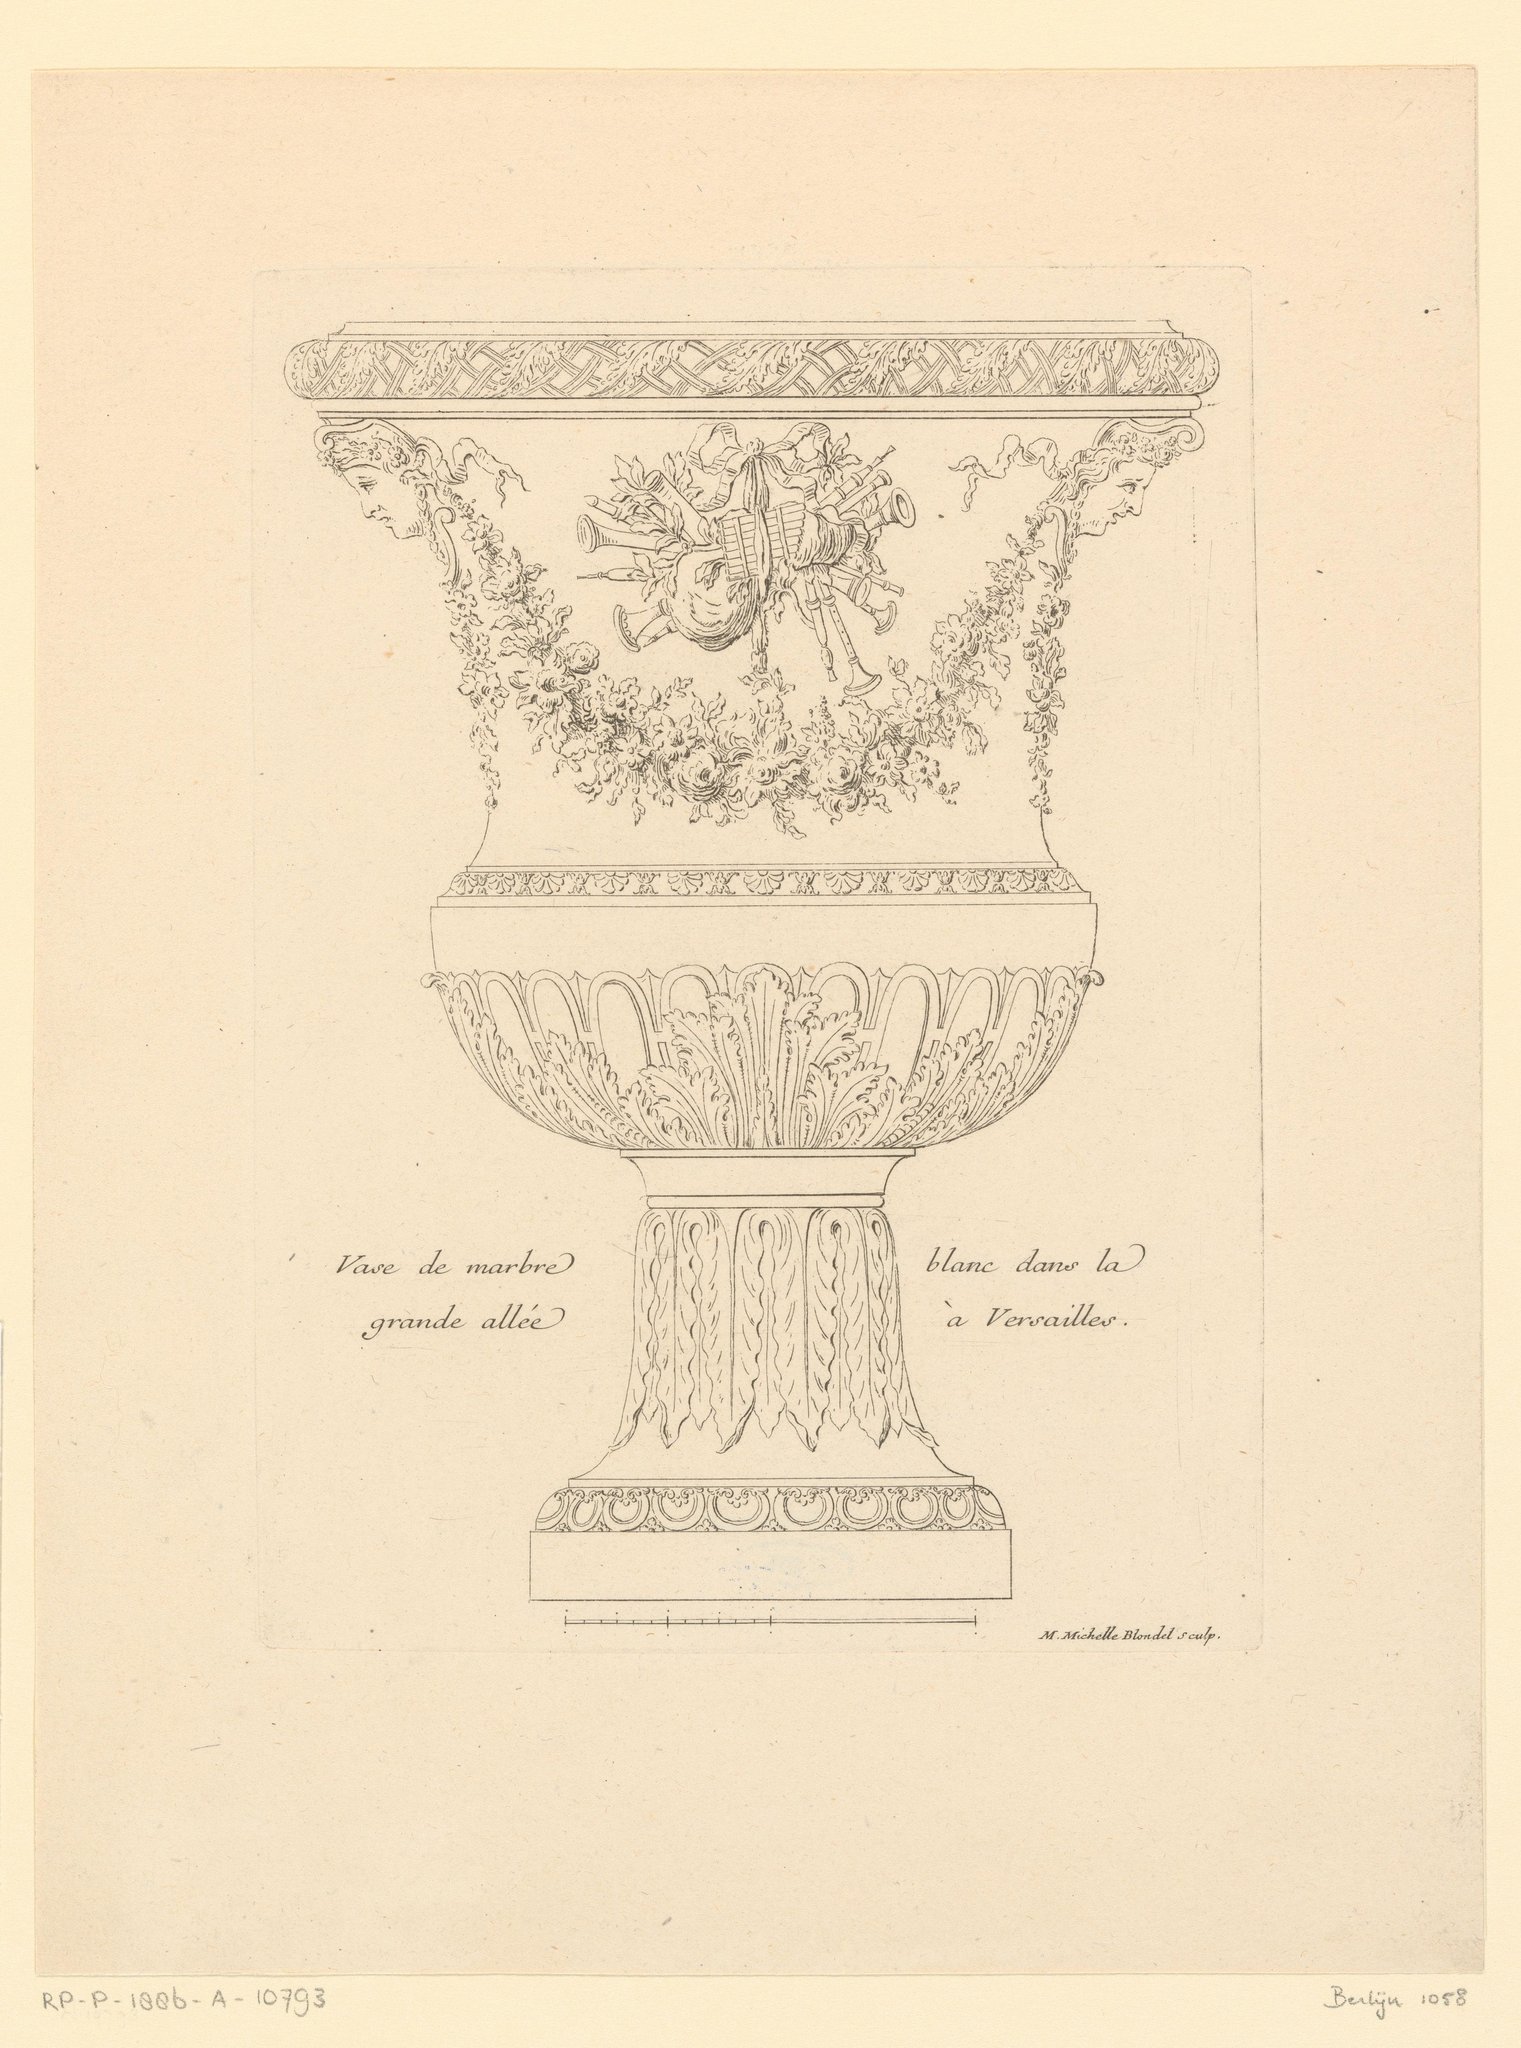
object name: ornament print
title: Profils et ornemens de vases (...)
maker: marie michelle blondel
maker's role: print maker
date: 1723-1774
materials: paper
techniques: etching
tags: musical instruments; group of musical instruments, mask, mascaron ~ ornament, ornament ~ festoon, garland, garden vase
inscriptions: collector's mark: Lugt 2228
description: Een geornamenteerde siervaas met muziekinstrumenten, een guirlande en twee maskers. Met tweeregelige Franse beschrijving.